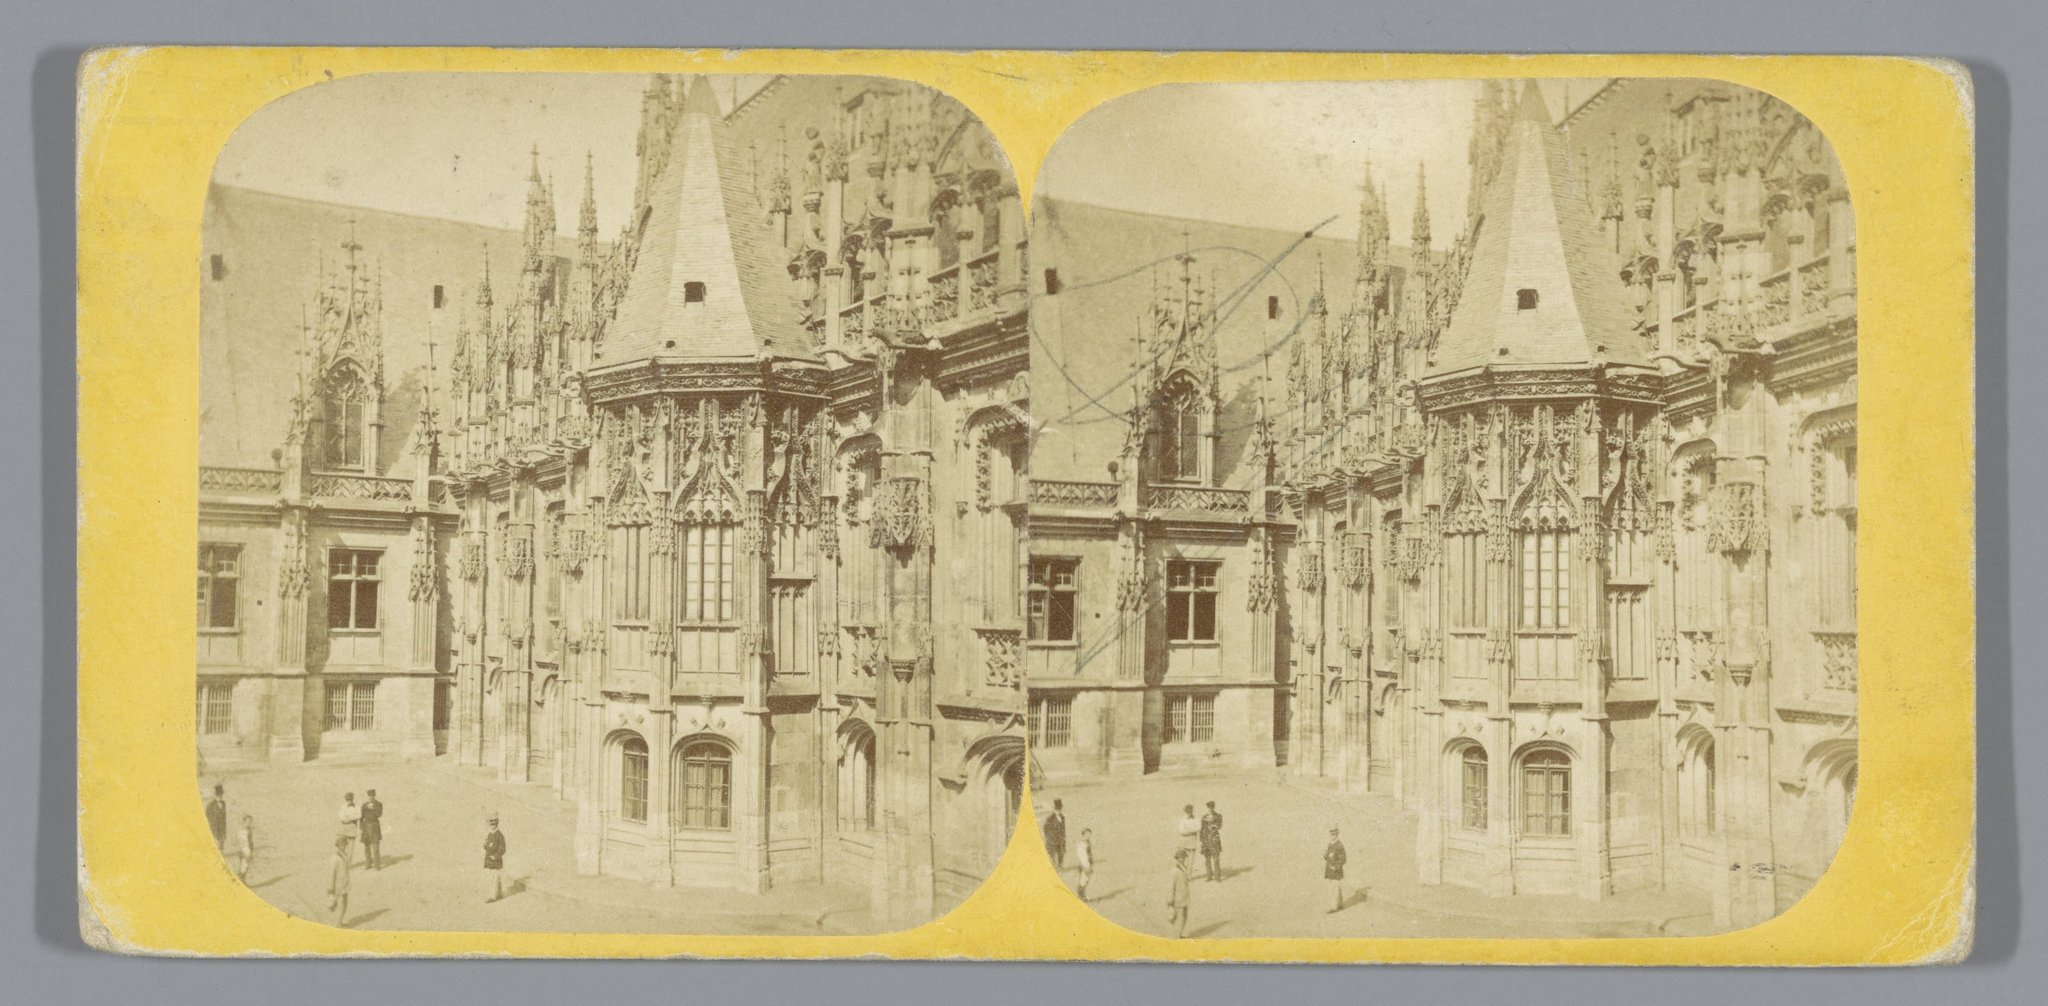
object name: stereograph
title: Deel van de gevel van het Palais de Justice te Rouen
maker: Anonymous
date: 1860-1880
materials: cardboard, photographic support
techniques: albumen print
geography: rouen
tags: court building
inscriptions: number: ‘No 19’